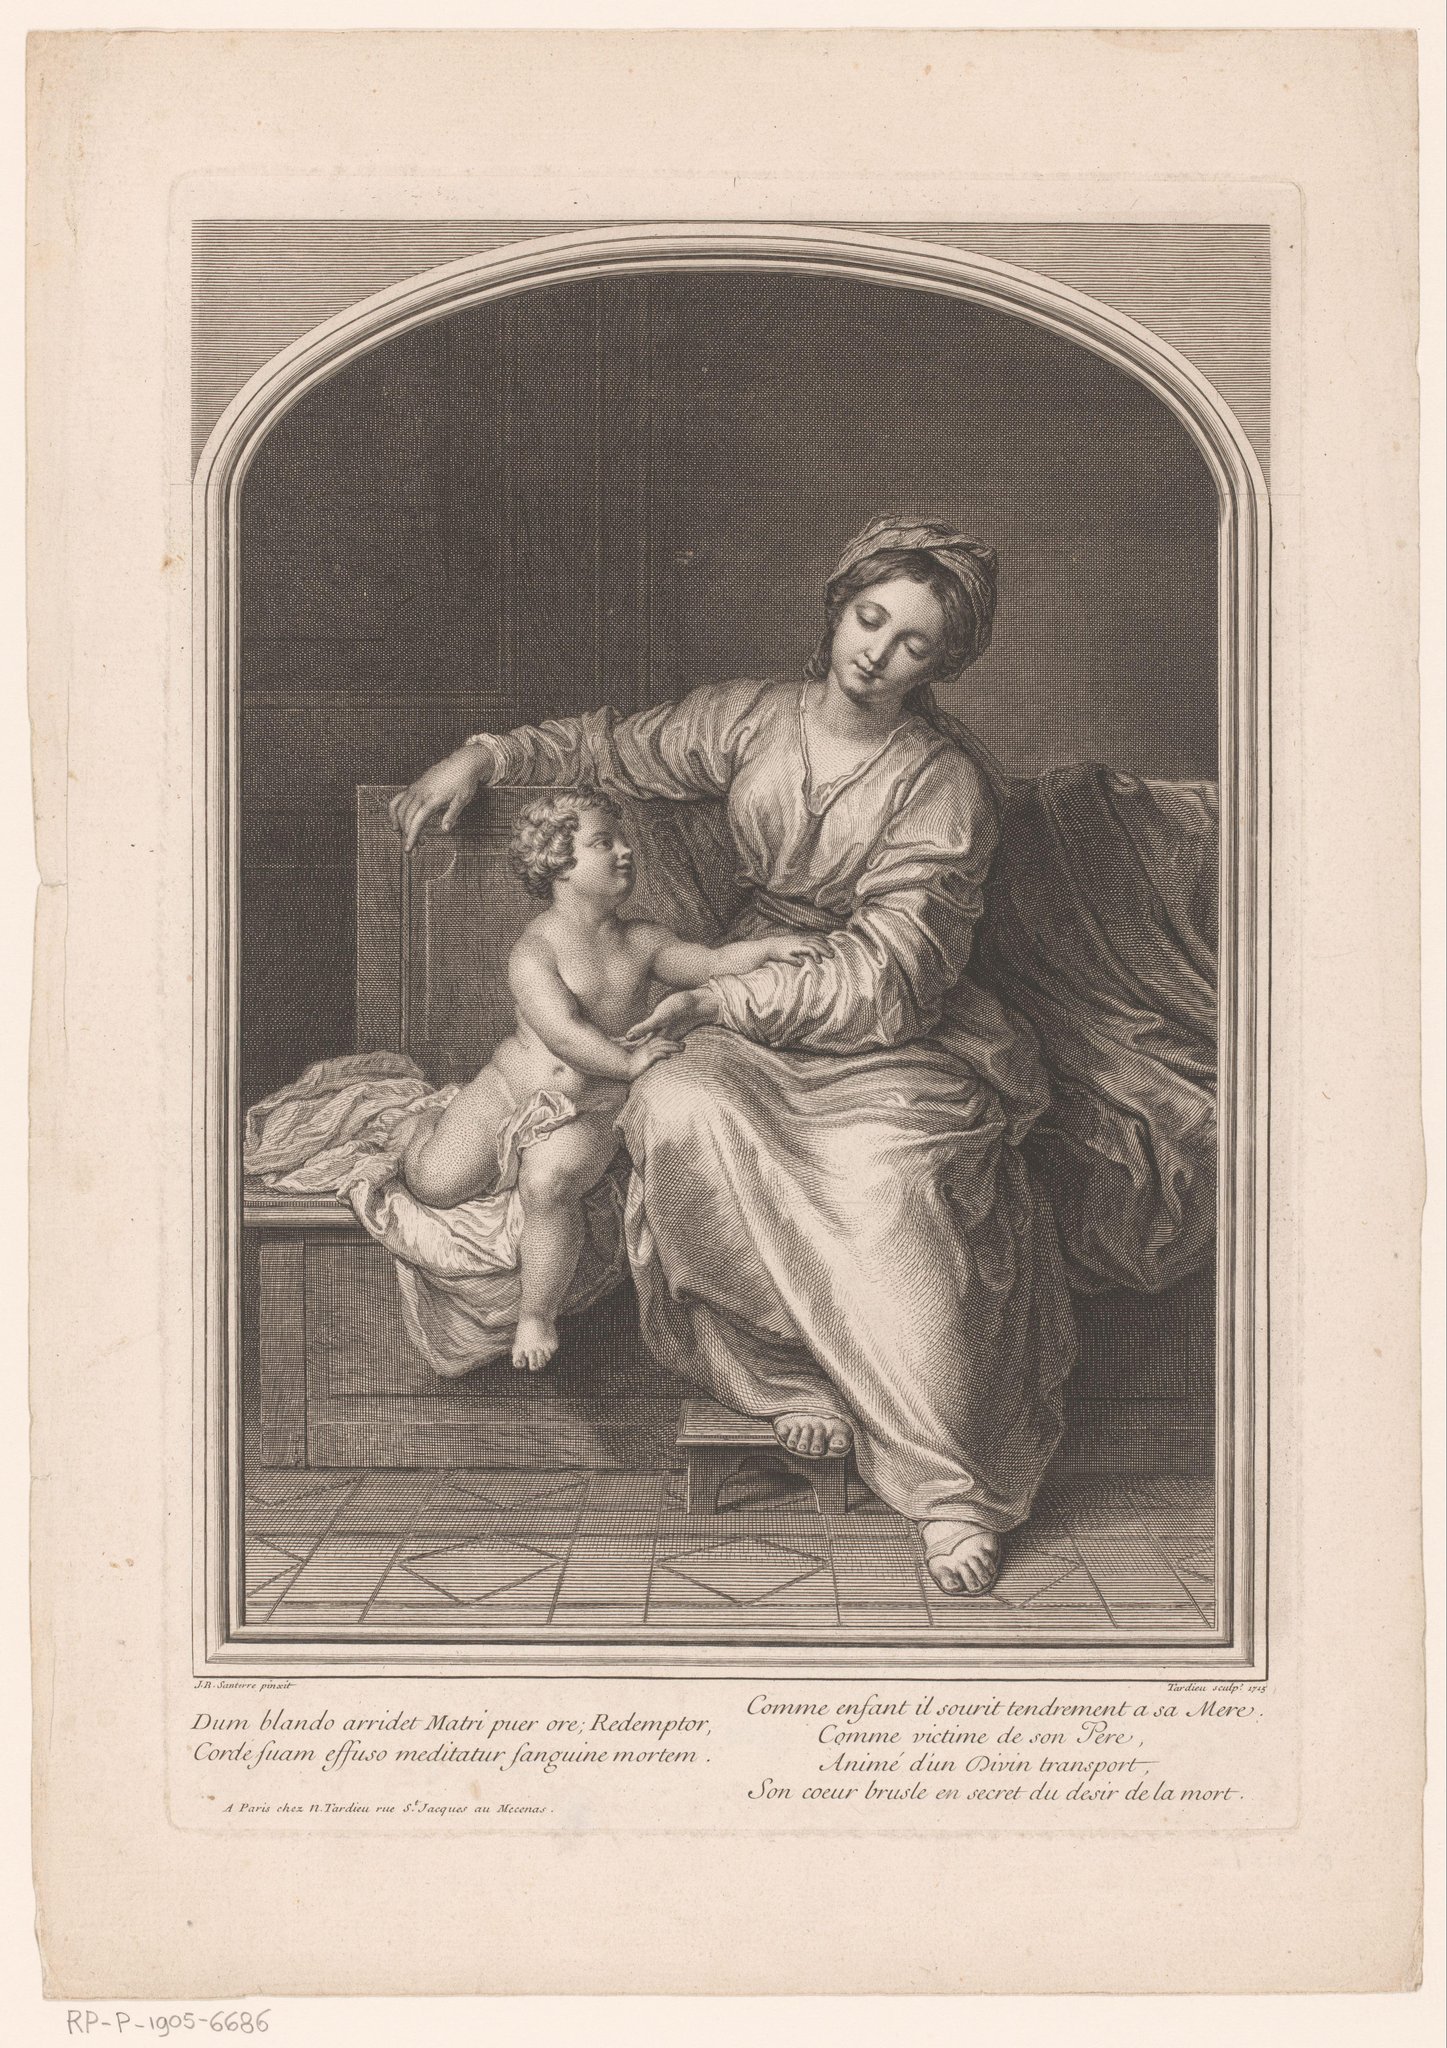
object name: print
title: Maria met kind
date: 1715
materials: paper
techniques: engraving, etching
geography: paris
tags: madonna: i.e. mary with the christ-child, christ-child looking or turning to mary ~ madonna-representations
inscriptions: collector's mark: Lugt 2228